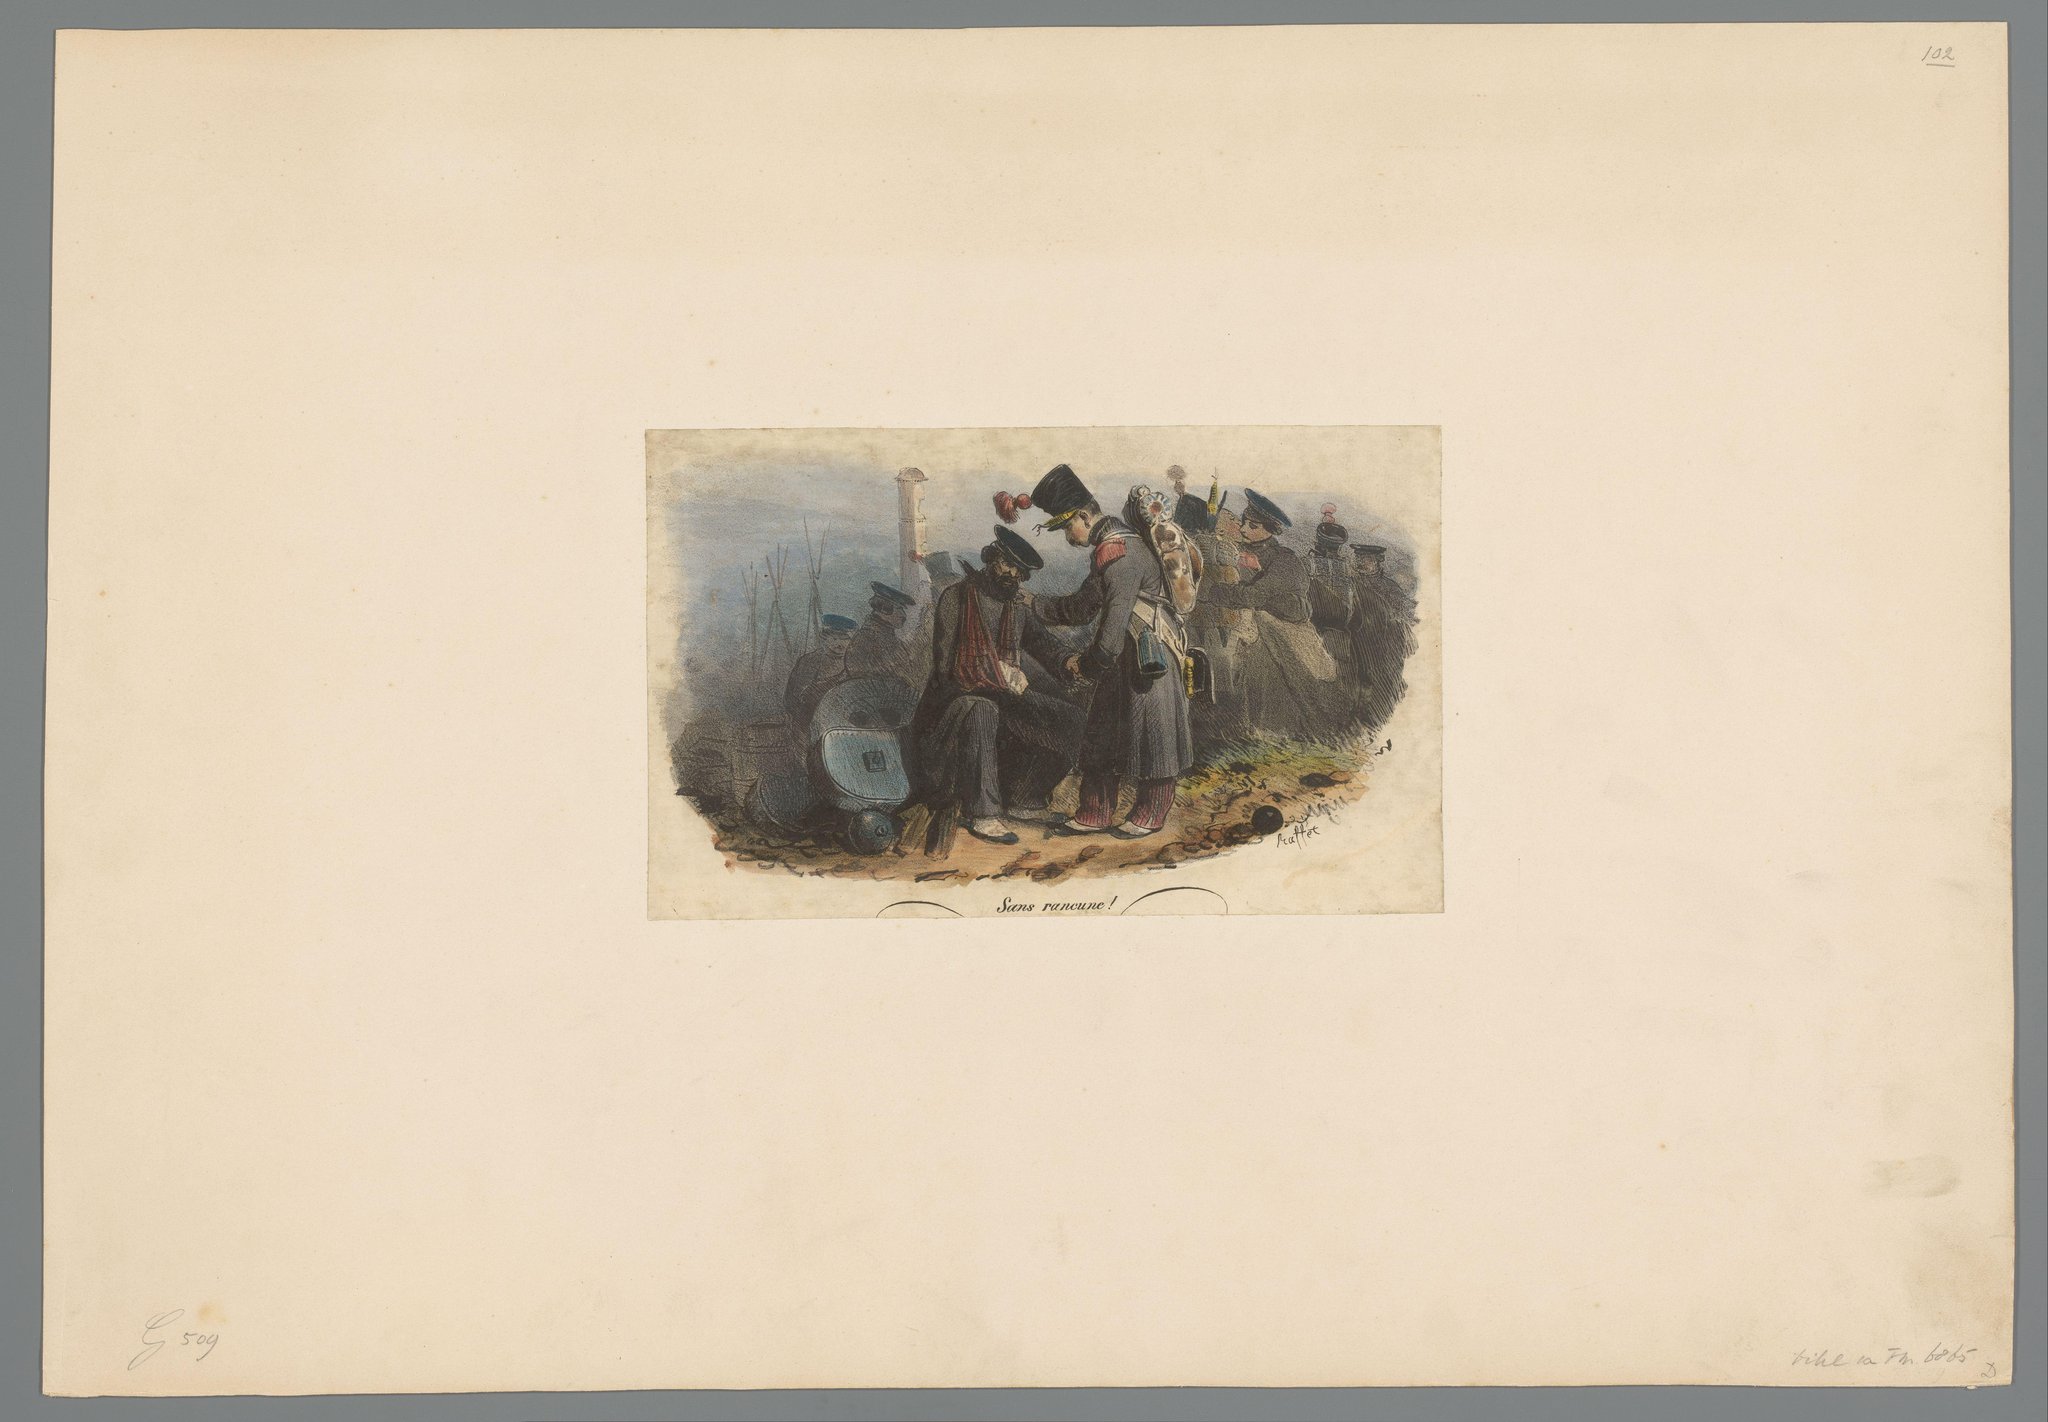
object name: titelprent, frontispice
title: Vignet met de verbroedering tussen Nederlandse en Franse troepen na het beleg van de citadel van Antwerpen, 1832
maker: denis auguste marie raffet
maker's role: draughtsman, print maker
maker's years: 1804-1860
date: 1833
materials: paper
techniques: hand coloring, lithograph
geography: paris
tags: the soldier; the soldier's life, the defeated (after the battle), antwerp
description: De verbroedering tussen Nederlandse en Franse troepen na het beleg van de Citadel van Antwerpen. Voorstelling gebruikt op als vignet op de omslag van de serie van 24 prenten over het beleg van de Citadel van Antwerpen, 30 november - 23 december 1832. Dit exemplaar uitgeknipt en opgeplakt.